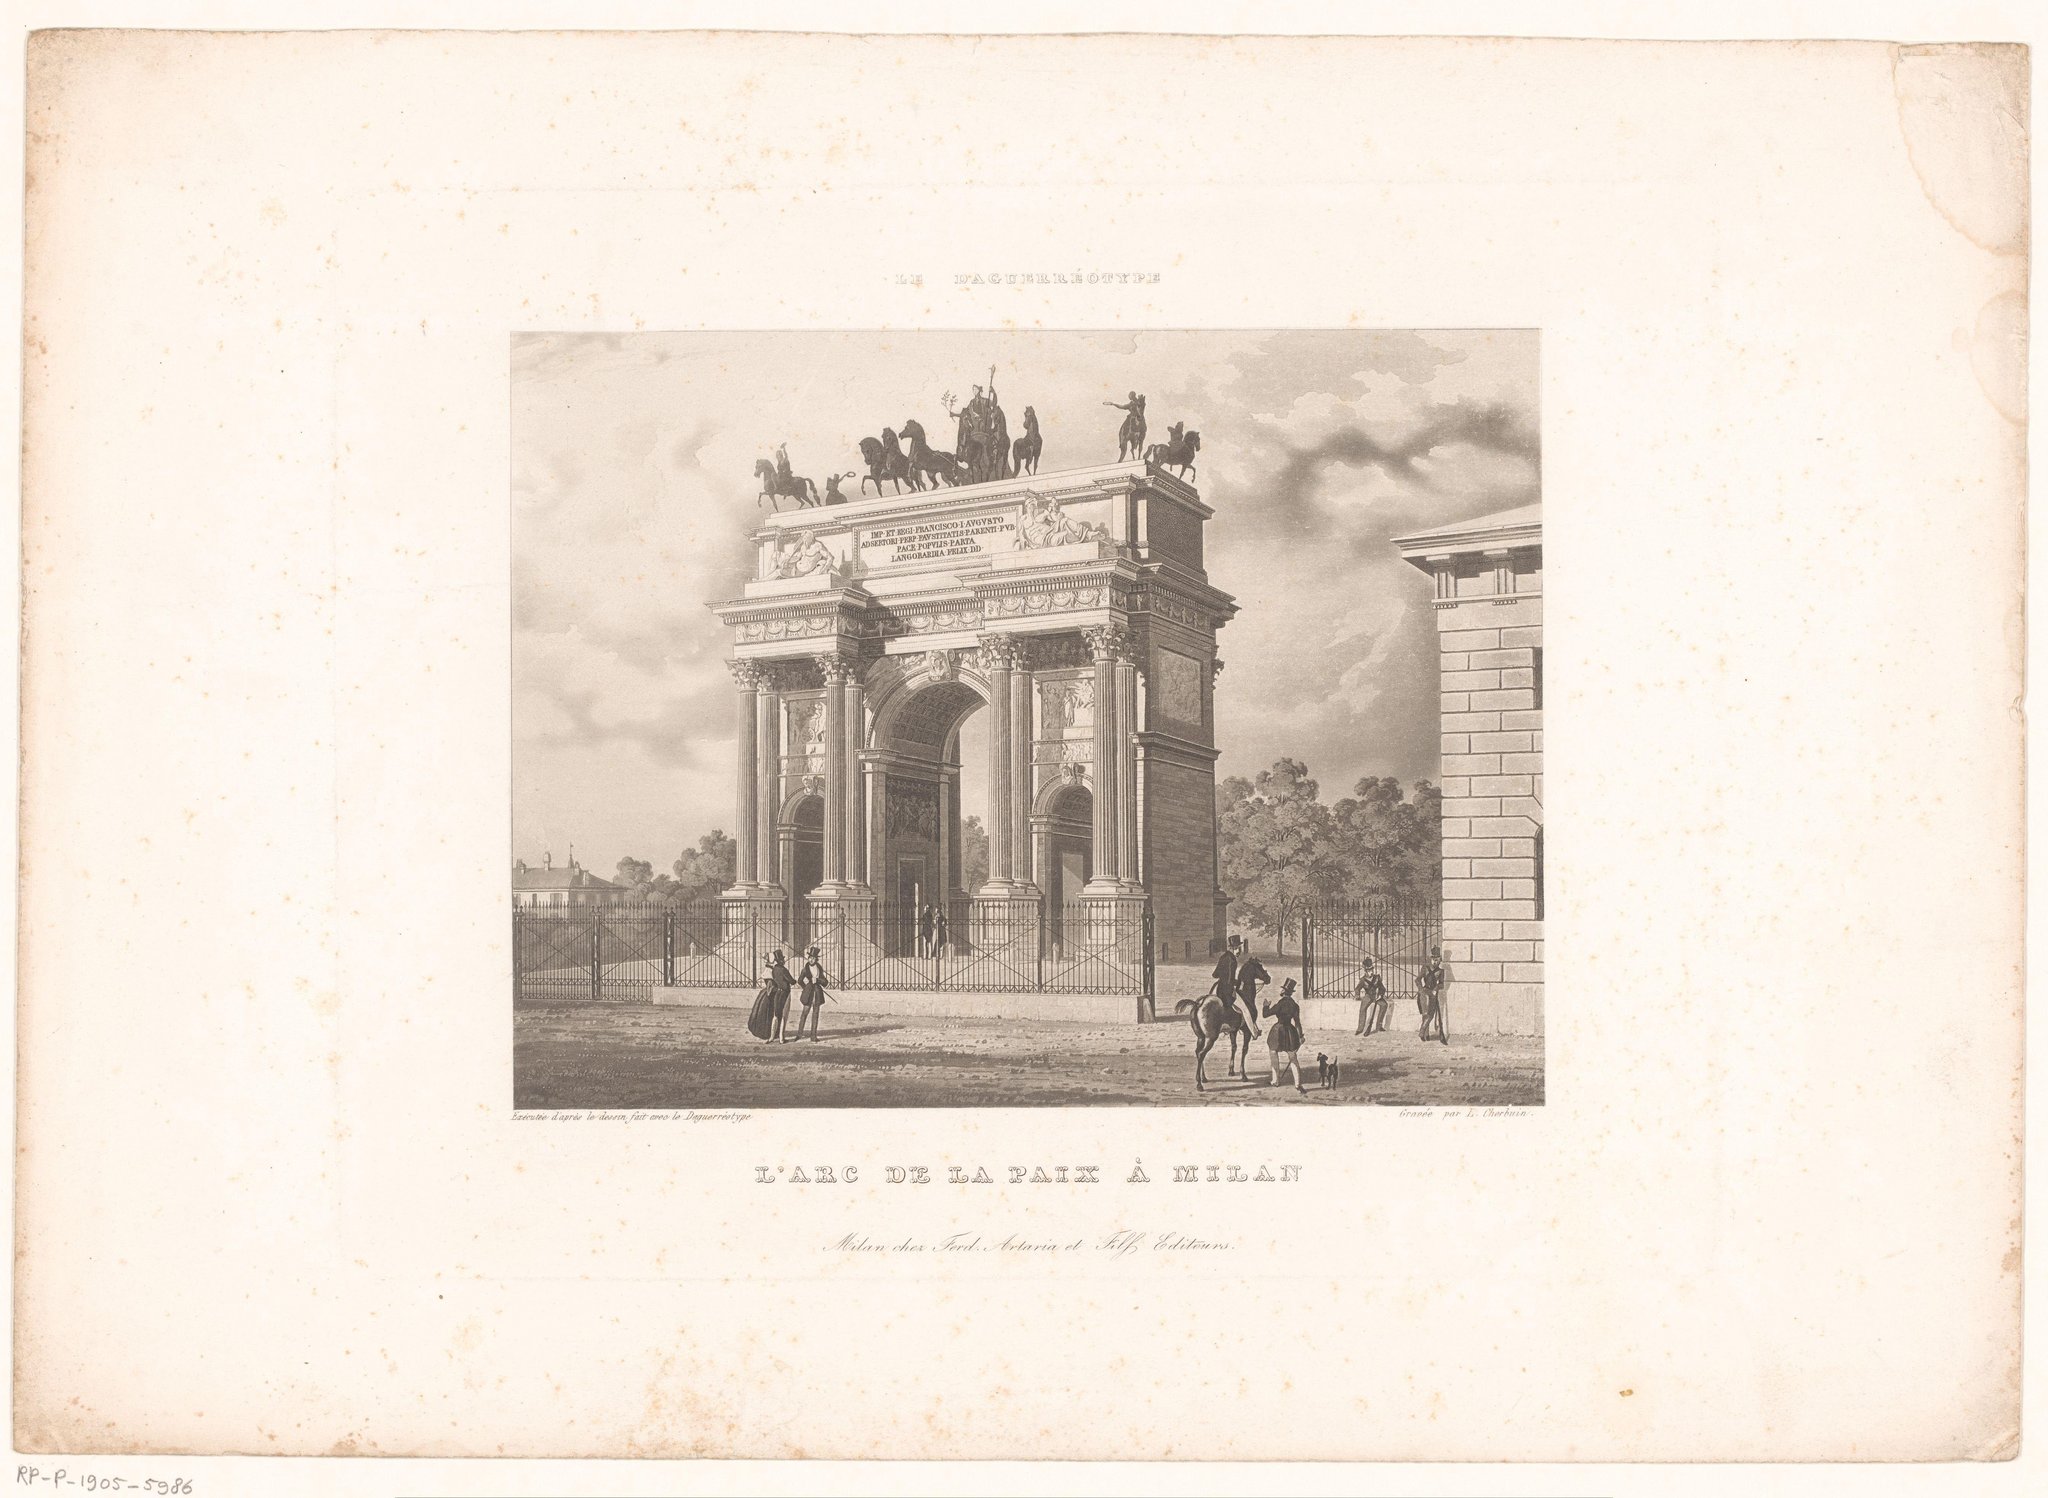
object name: print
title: L'Arc de la Paix à Milan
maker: louis cherbuin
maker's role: print maker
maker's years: 1810-1875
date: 1820-1875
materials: paper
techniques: aquatint, etching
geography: milan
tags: city-view in general; 'veduta', triumphal arch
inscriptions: collector's mark: Lugt 2228, check stamp